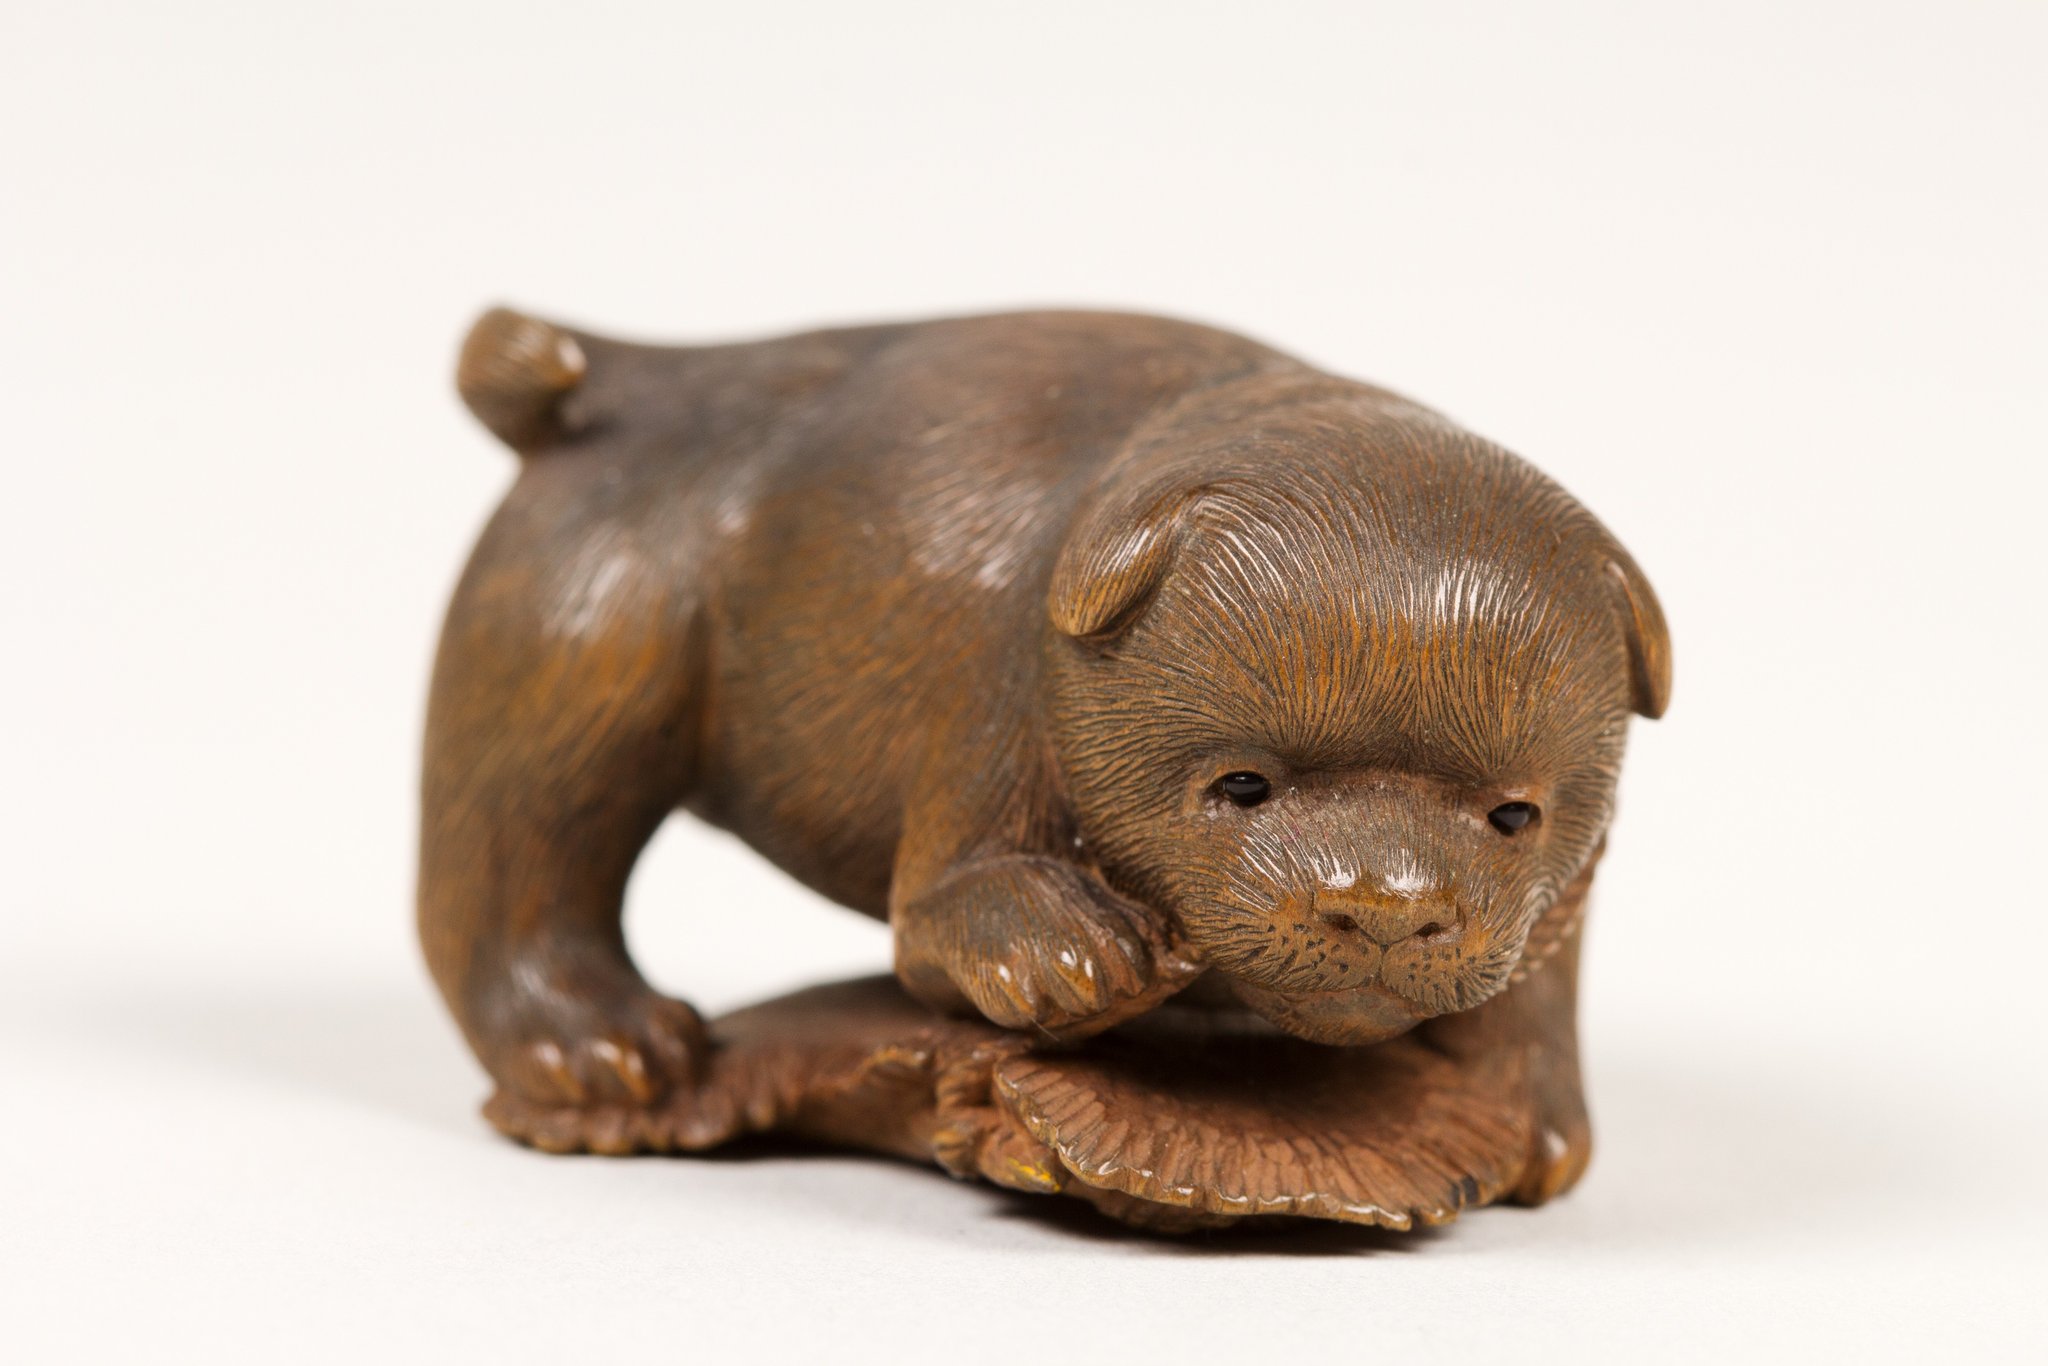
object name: netsuke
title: Netsuke of Puppy on Straw Mat Biting String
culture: japanese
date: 1615-1868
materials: pearl, wood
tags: dogs